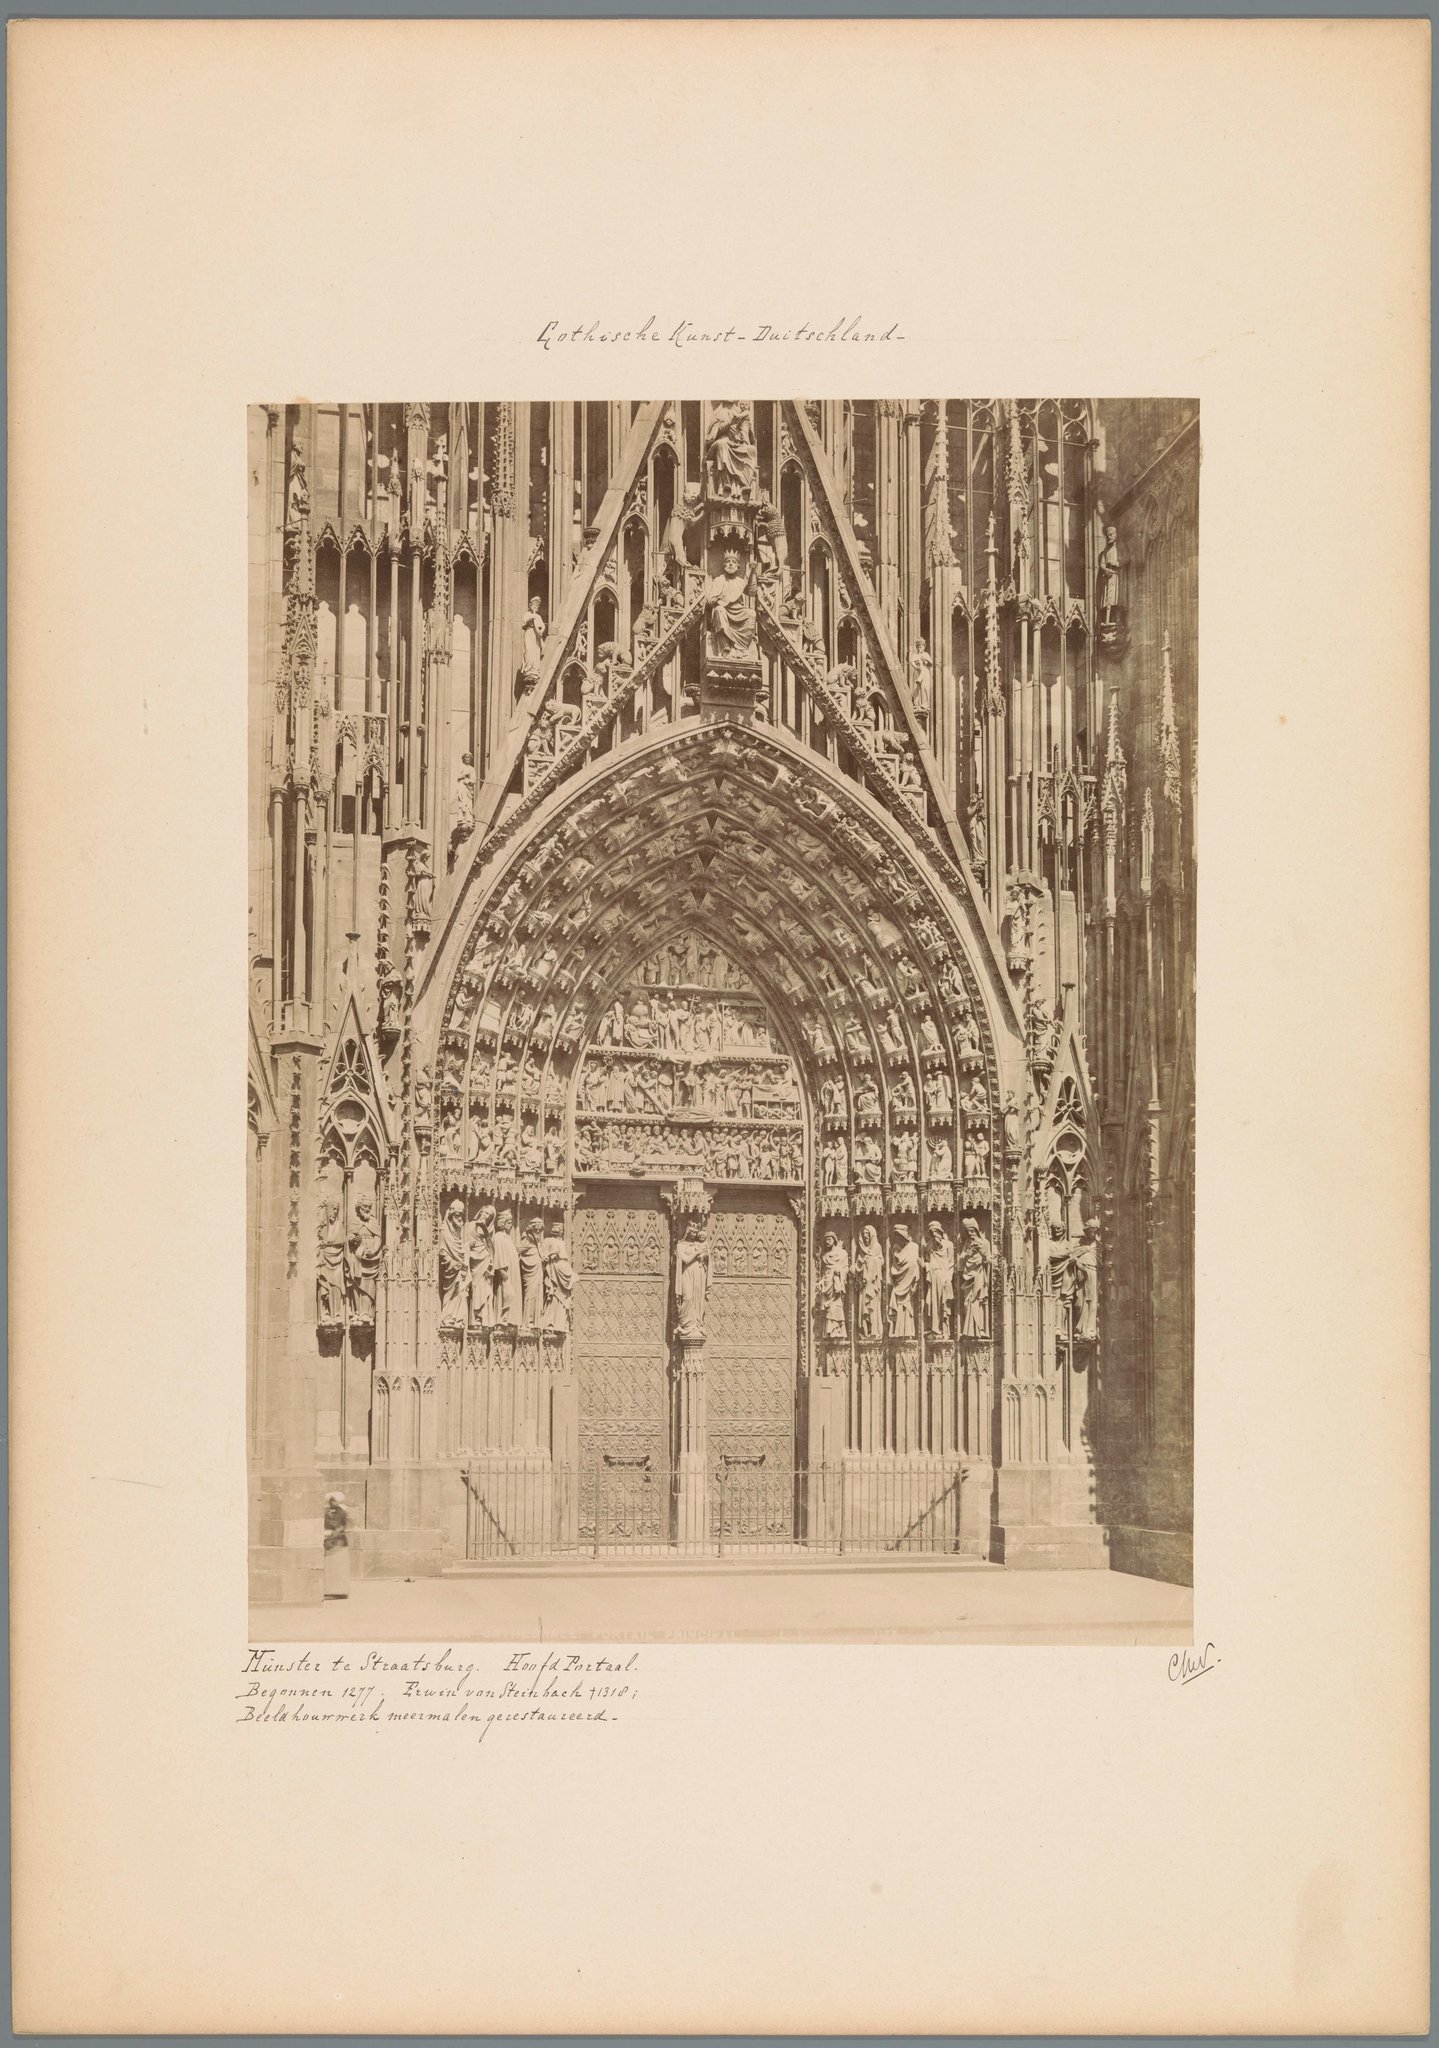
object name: photograph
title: Portaal van de kathedraal de Notre-Dame te Straatsburg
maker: Anonymous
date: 1875-1900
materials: cardboard, photographic support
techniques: albumen print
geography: straatsburg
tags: parts of church exterior and annexes: portal, sculpture (+ relief ~ sculpture)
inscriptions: inscription: ‘Gothische Kunst - Duitschland.’, inscription: ‘CWN.’, collector's mark: ‘INSTITUUT VOOR KUNST-NIJVERHEIDSONDERWIJS GABRIËL METSUSTRAAT No. 16 AMSTERDAM’, collector's mark: ‘KUNSTNIJVERHEIDSCHOOL QUELLINUS AMSTERDAM FRANS HALSSTRAAT 14.’